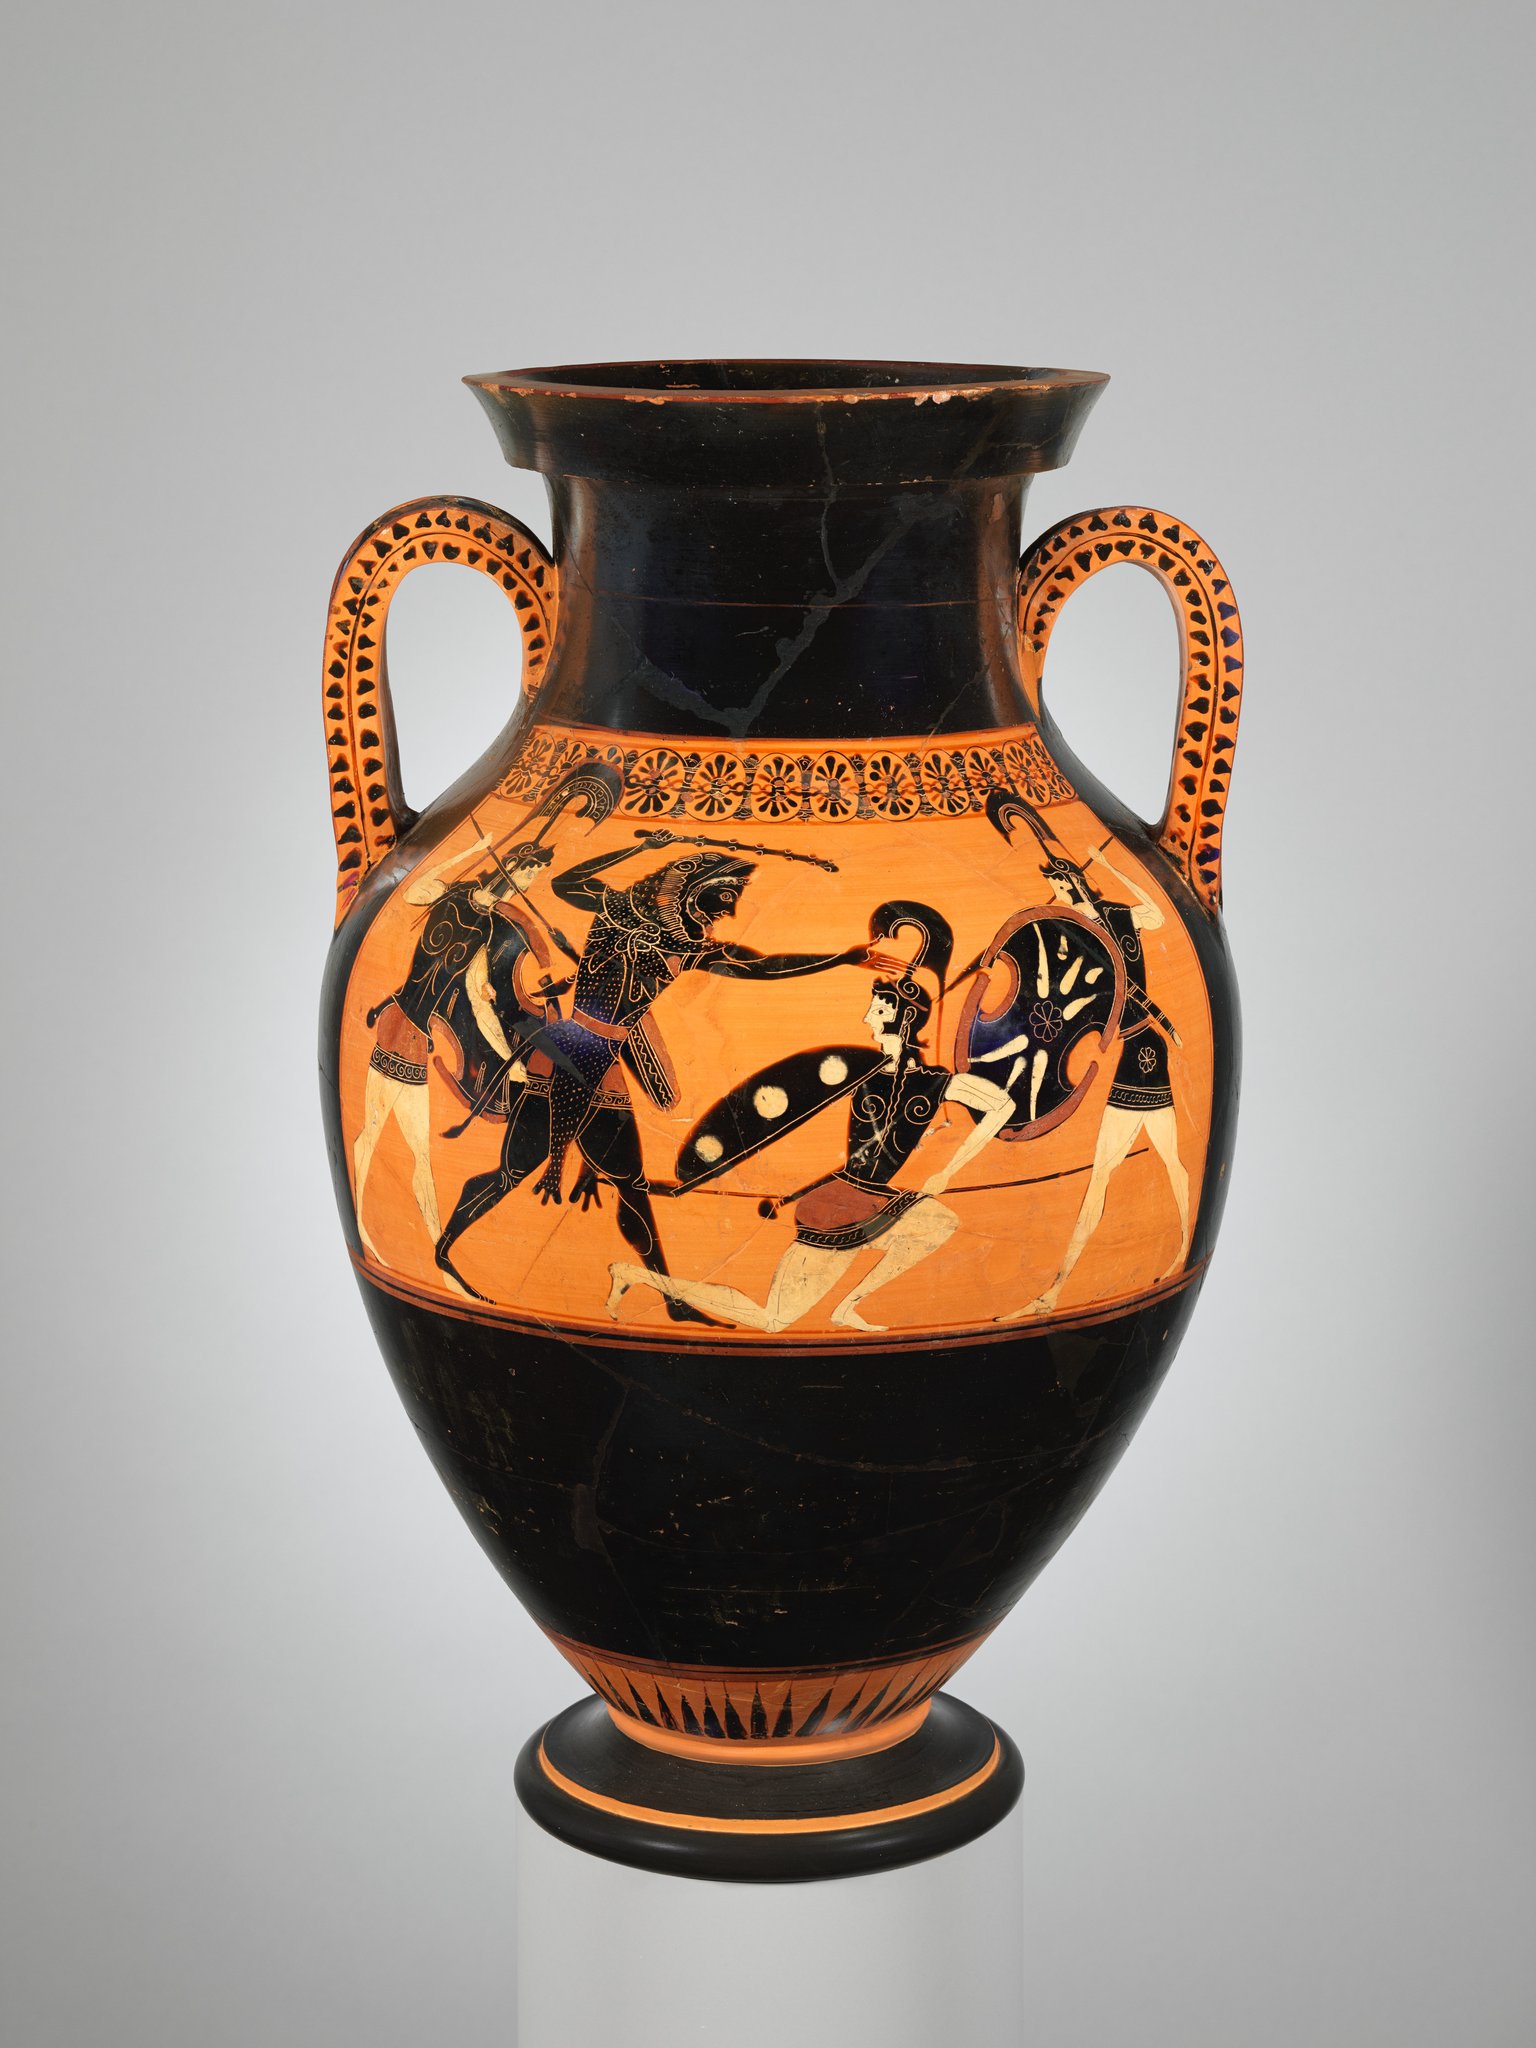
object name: amphora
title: Terracotta amphora (jar)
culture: greek, attic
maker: bateman group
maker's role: artist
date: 530 BCE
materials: terracotta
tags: dionysus,amazons,satyrs,herakles